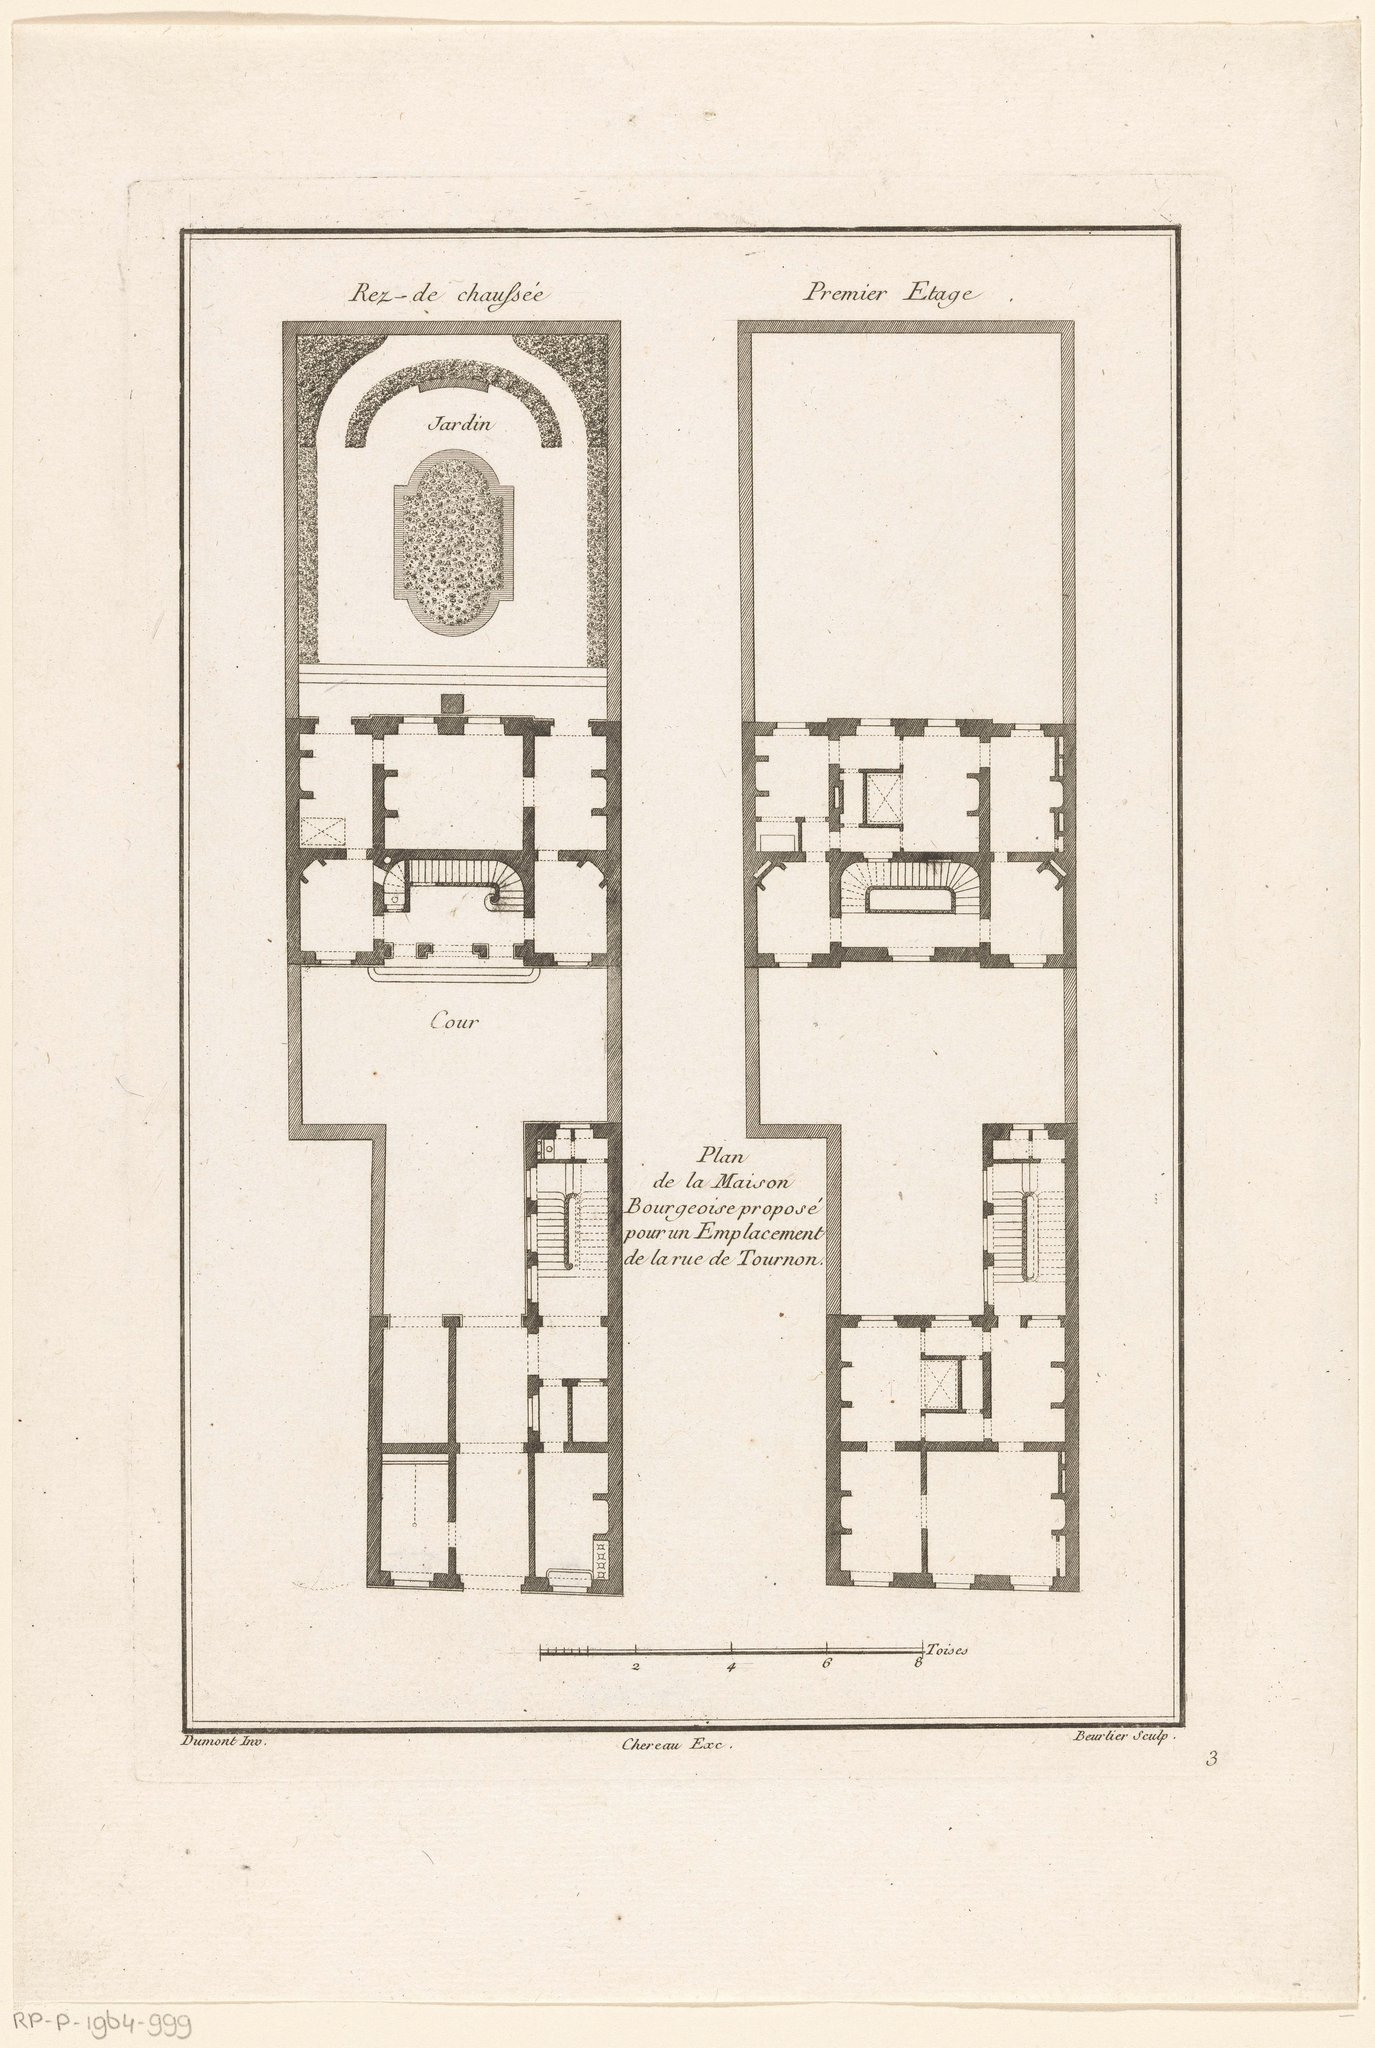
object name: print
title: Plan de la Maison Bourgeoise proposé pour un Emplacement de la rue de Tournon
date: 1730-1790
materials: paper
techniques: engraving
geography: paris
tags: plan ~ architecture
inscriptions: collector's mark: Lugt 2760, collector's mark: Lugt 2228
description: Plattegronden van de begane grond en eerste verdieping van een huis.